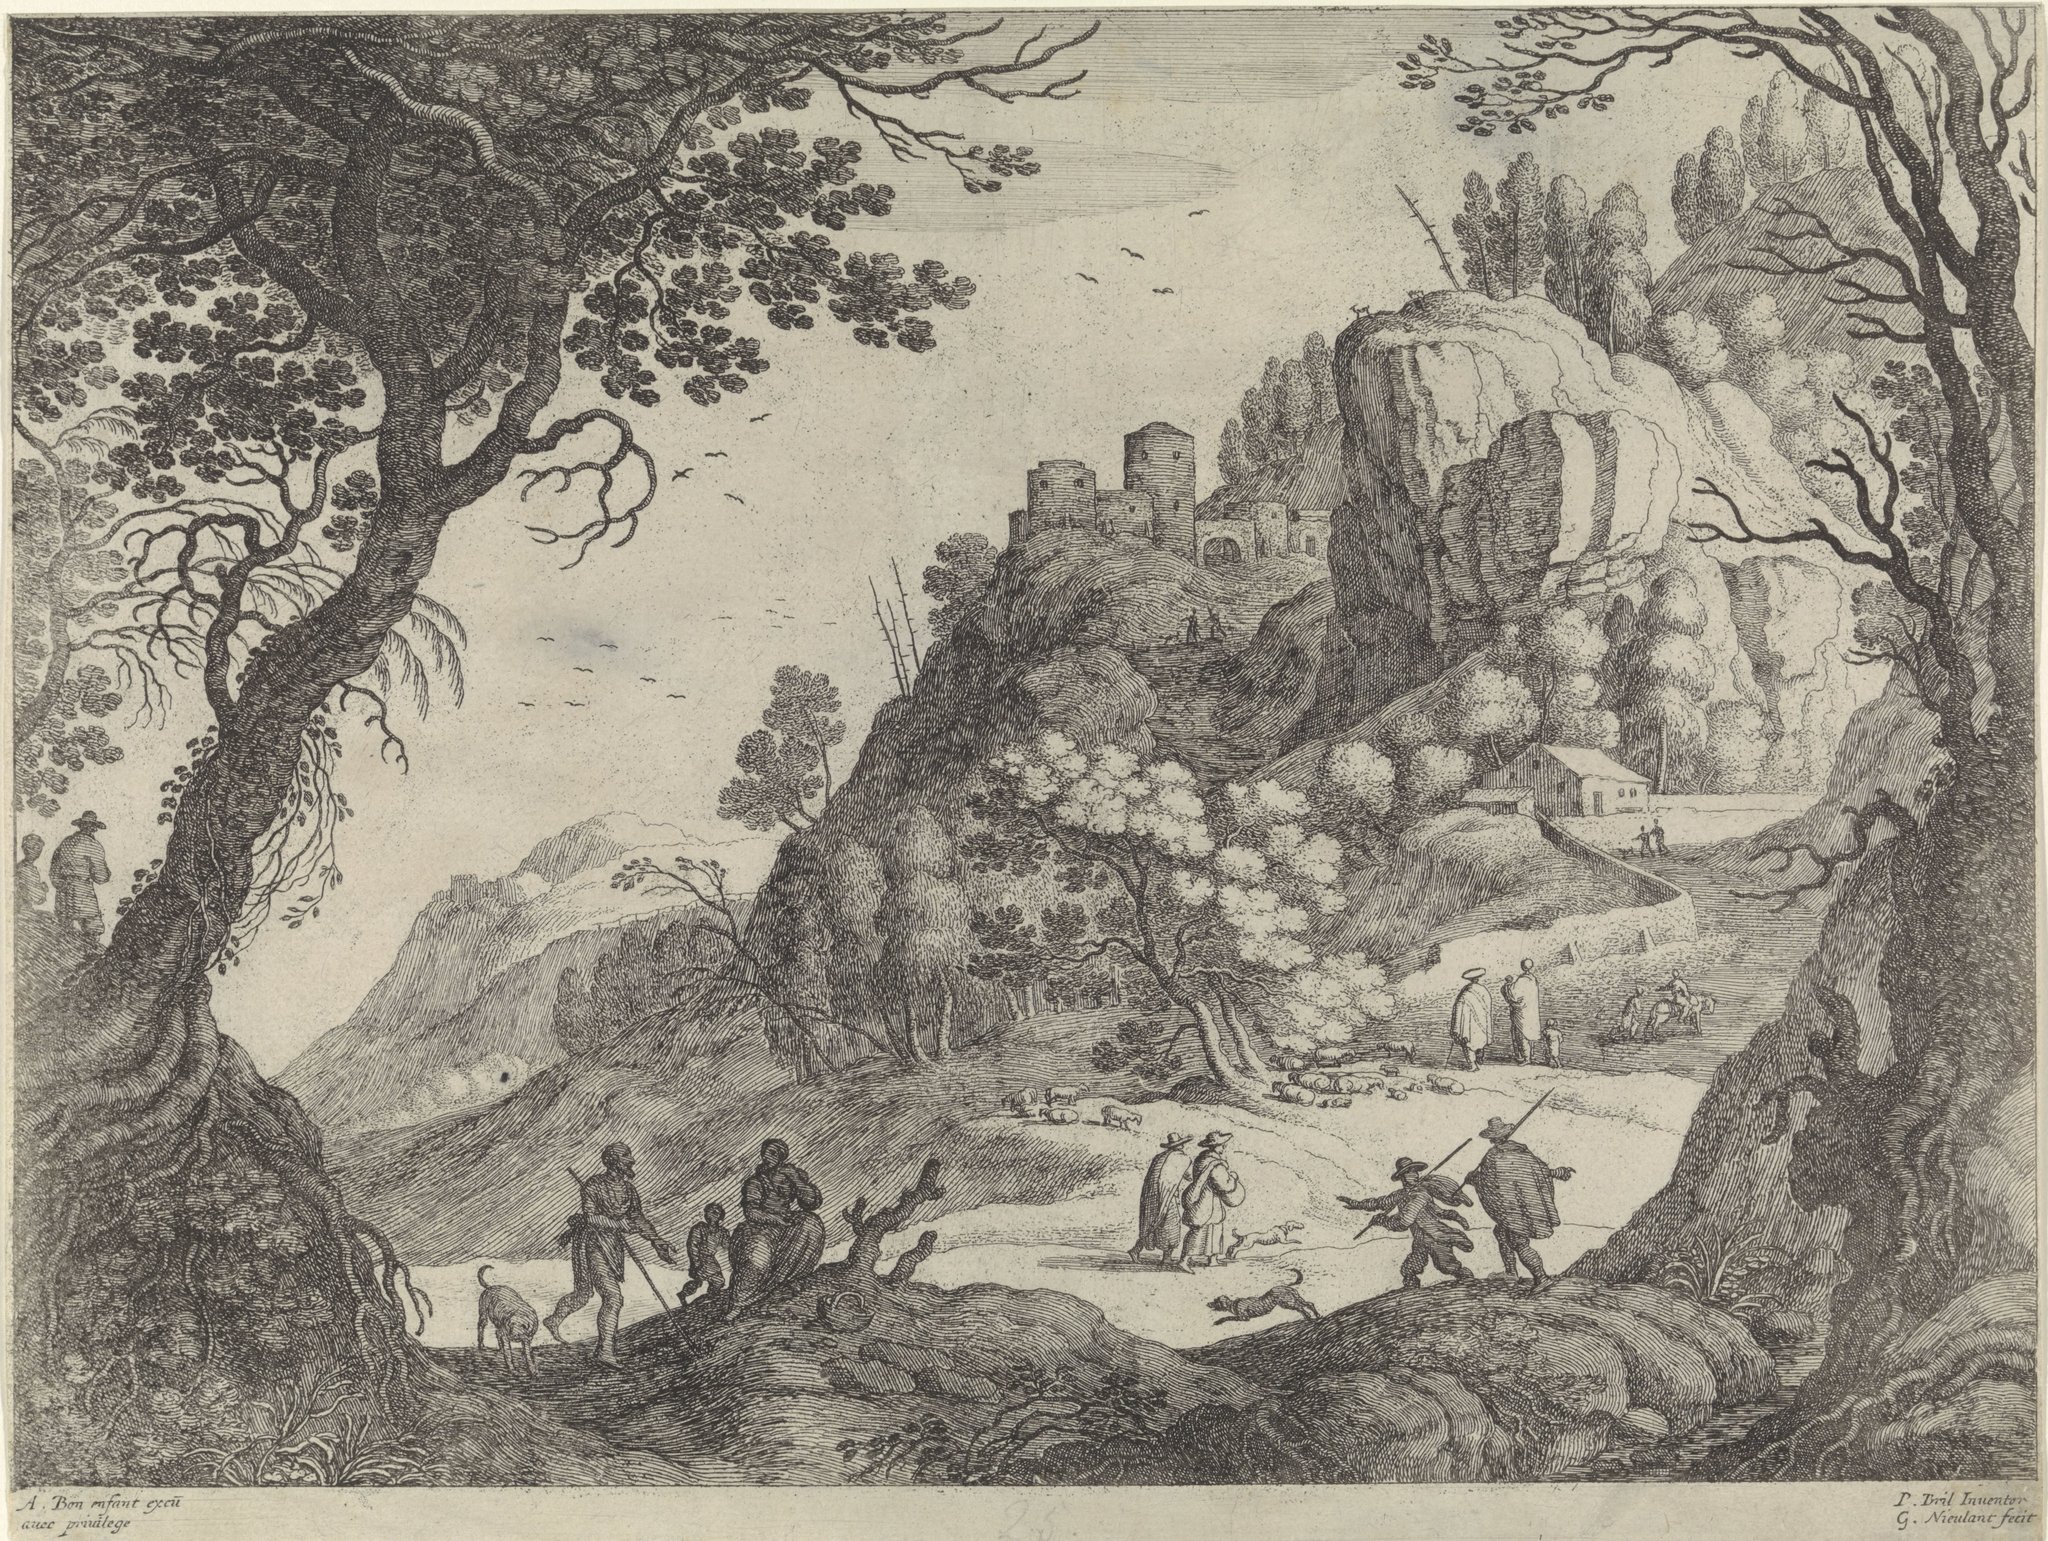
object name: print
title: Berglandschap met figuren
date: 1594-1635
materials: paper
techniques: engraving, etching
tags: castle, landscapes in the temperate zone (+ landscape with figures, staffage), dog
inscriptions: collector's mark: Lugt 2228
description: Italiaans berglandschap met verschillende figuren. Links een man, die een zittende vrouw aanspreekt, en twee mannen met een hond. Op de berg ligt een kasteel.